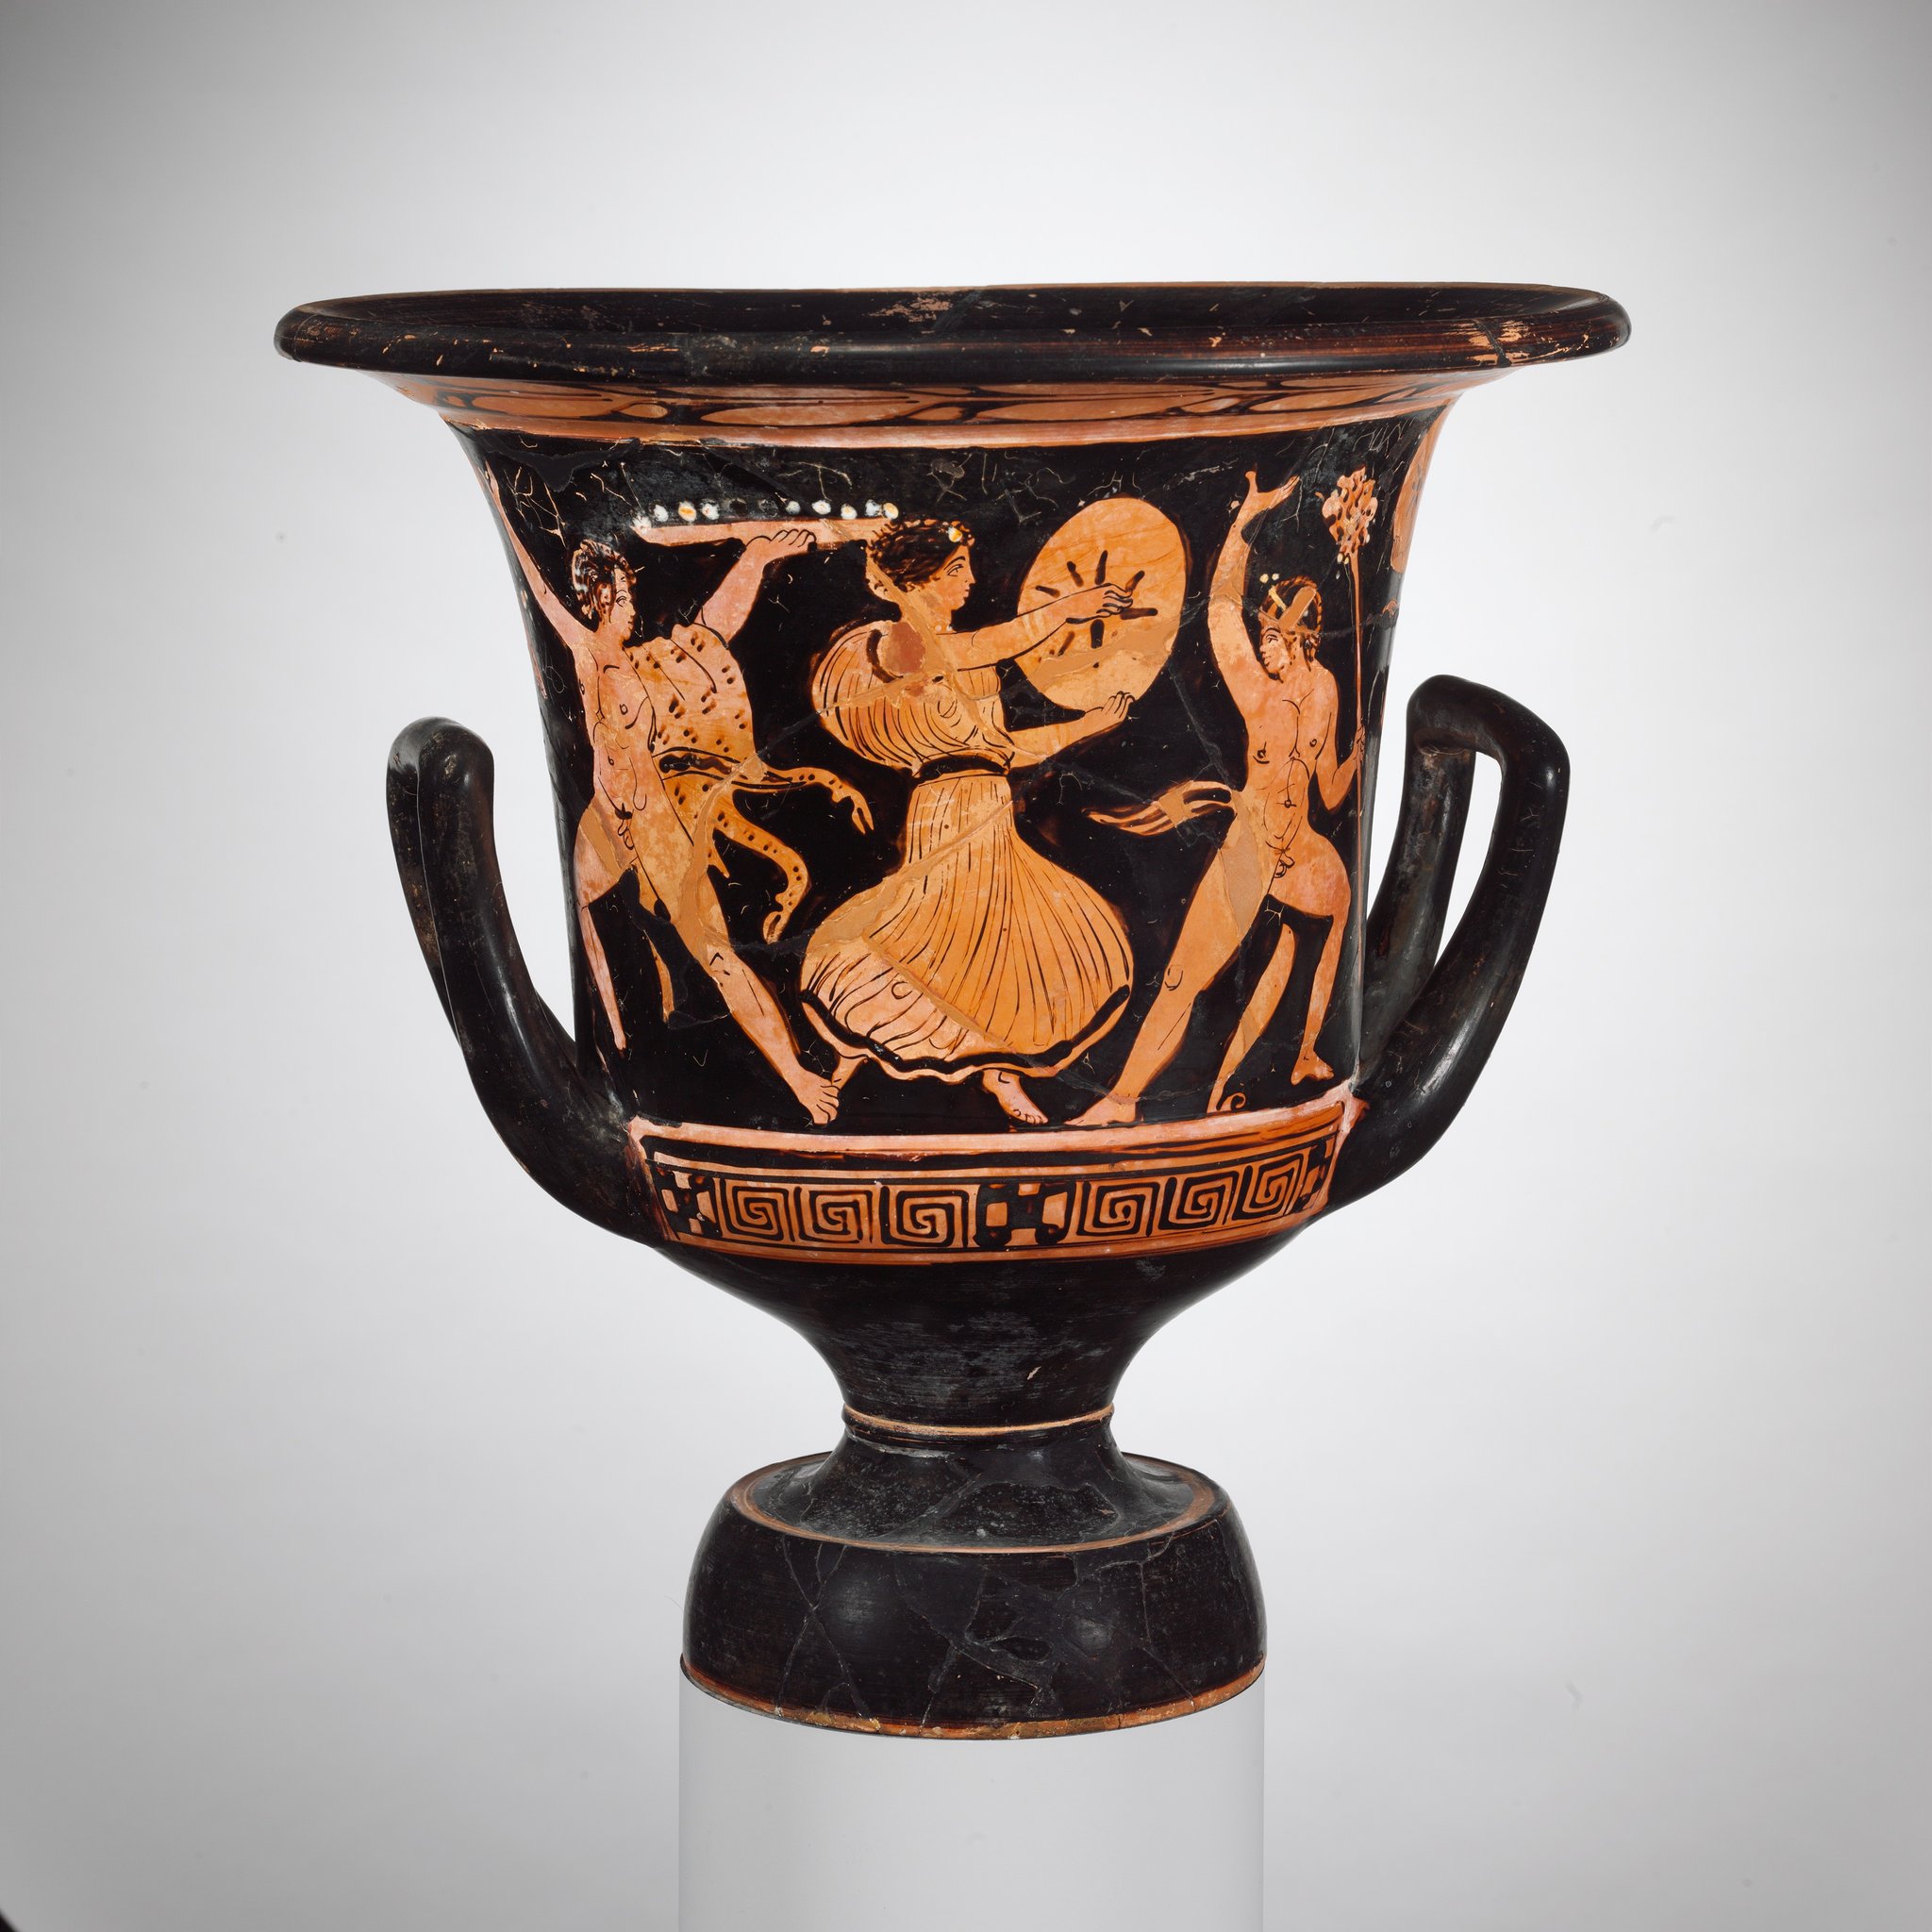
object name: calyx krater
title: Terracotta calyx-krater (vase for mixing wine and water)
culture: greek, attic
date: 400-368 BCE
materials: terracotta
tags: nike,maenads,satyrs,horses,chariots